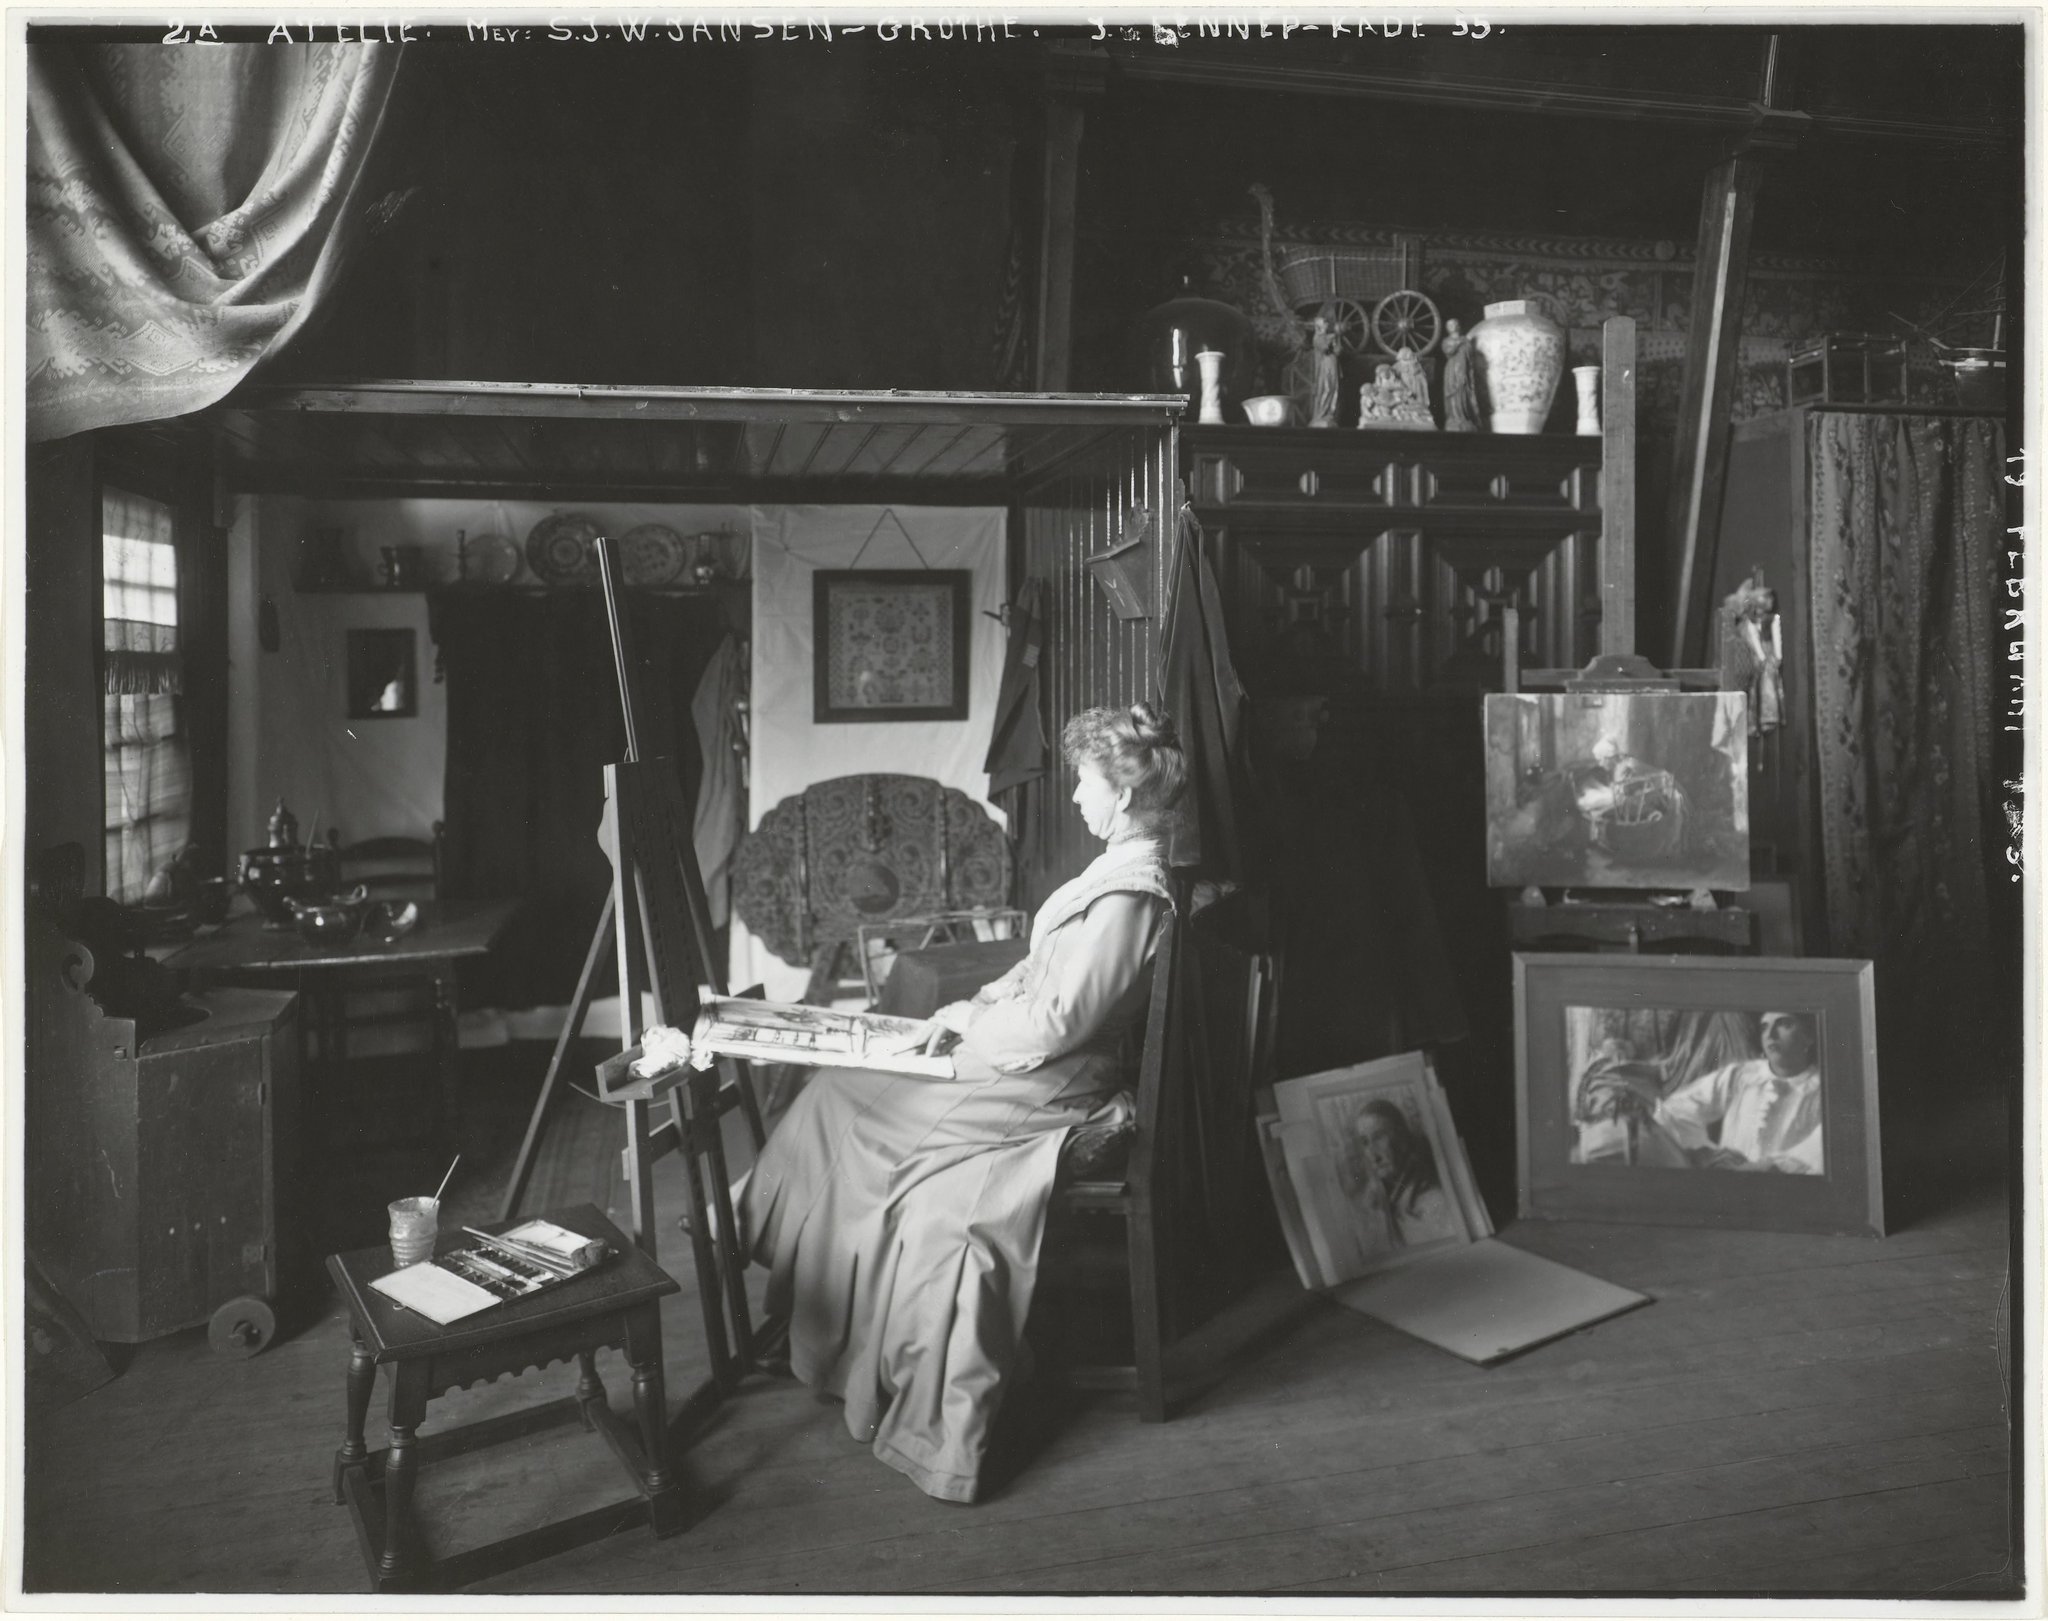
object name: later print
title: S.J.W. Jansen-Grothe in haar atelier aan de Jacob van Lennepkade 55 in Amsterdam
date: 1903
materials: paper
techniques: gelatin silver print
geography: amsterdam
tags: painter at work, in his studio, amsterdam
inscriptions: inscription: ‘2A. ATELIE MEV: S.J.W. JANSEN - GROTHE J. V. LENNEPKADE 55/ 19 FEBRUARI 1903’, copyright notice: ‘World Copyright by W.M.A. Deppe’